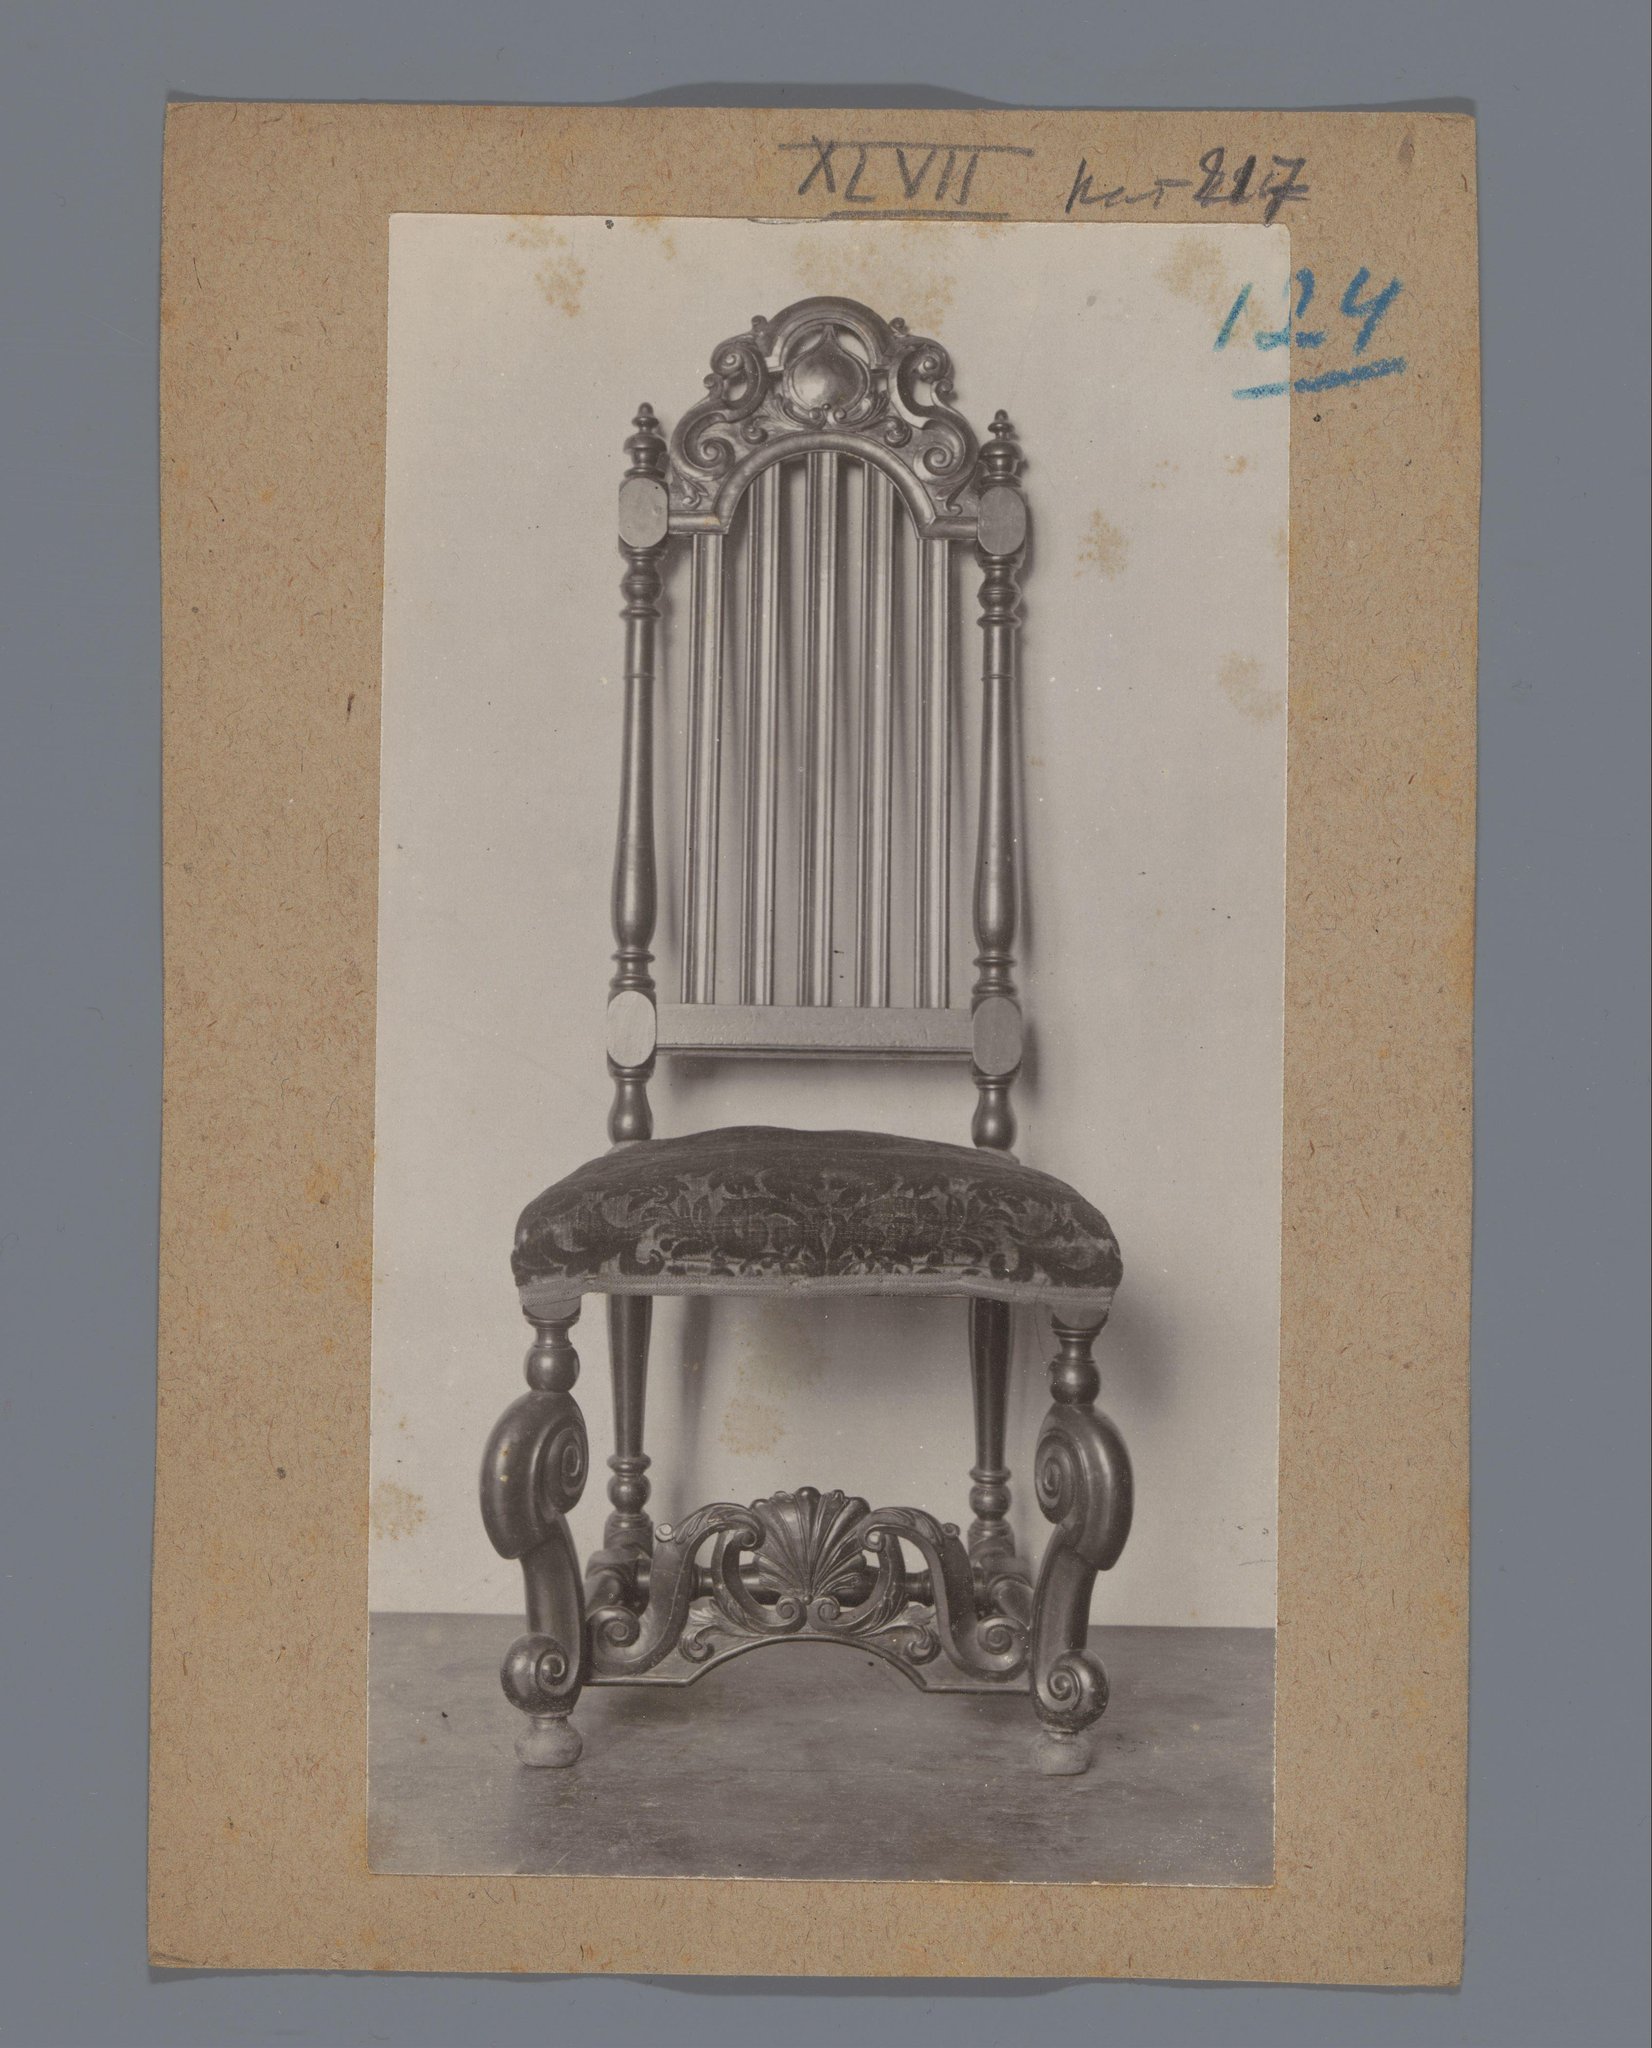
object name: photograph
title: Stoel van notenhout gedecoreerd met S-voluten, acanthusblad en een hartvormig schild in het Rijksmuseum te Amsterdam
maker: Anonymous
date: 1875-1900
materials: photographic support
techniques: matte daylight collodion silver print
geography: amsterdam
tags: acanthus ~ ornament, scallop, shell ~ ornament - aa - stylized, chair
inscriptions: collector's mark: ‘Kunstnijverheidschool Quellinus Amsterdam Frans Halsstraat 14.’, collector's mark: ‘Instituut voor kunst-nijverheidsonderwijs Gabriël Metsustraat No. 16, Amsterdam’, number: ‘XLVII kat 217 124’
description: Zie voor het originele object BK-AM-24-A.